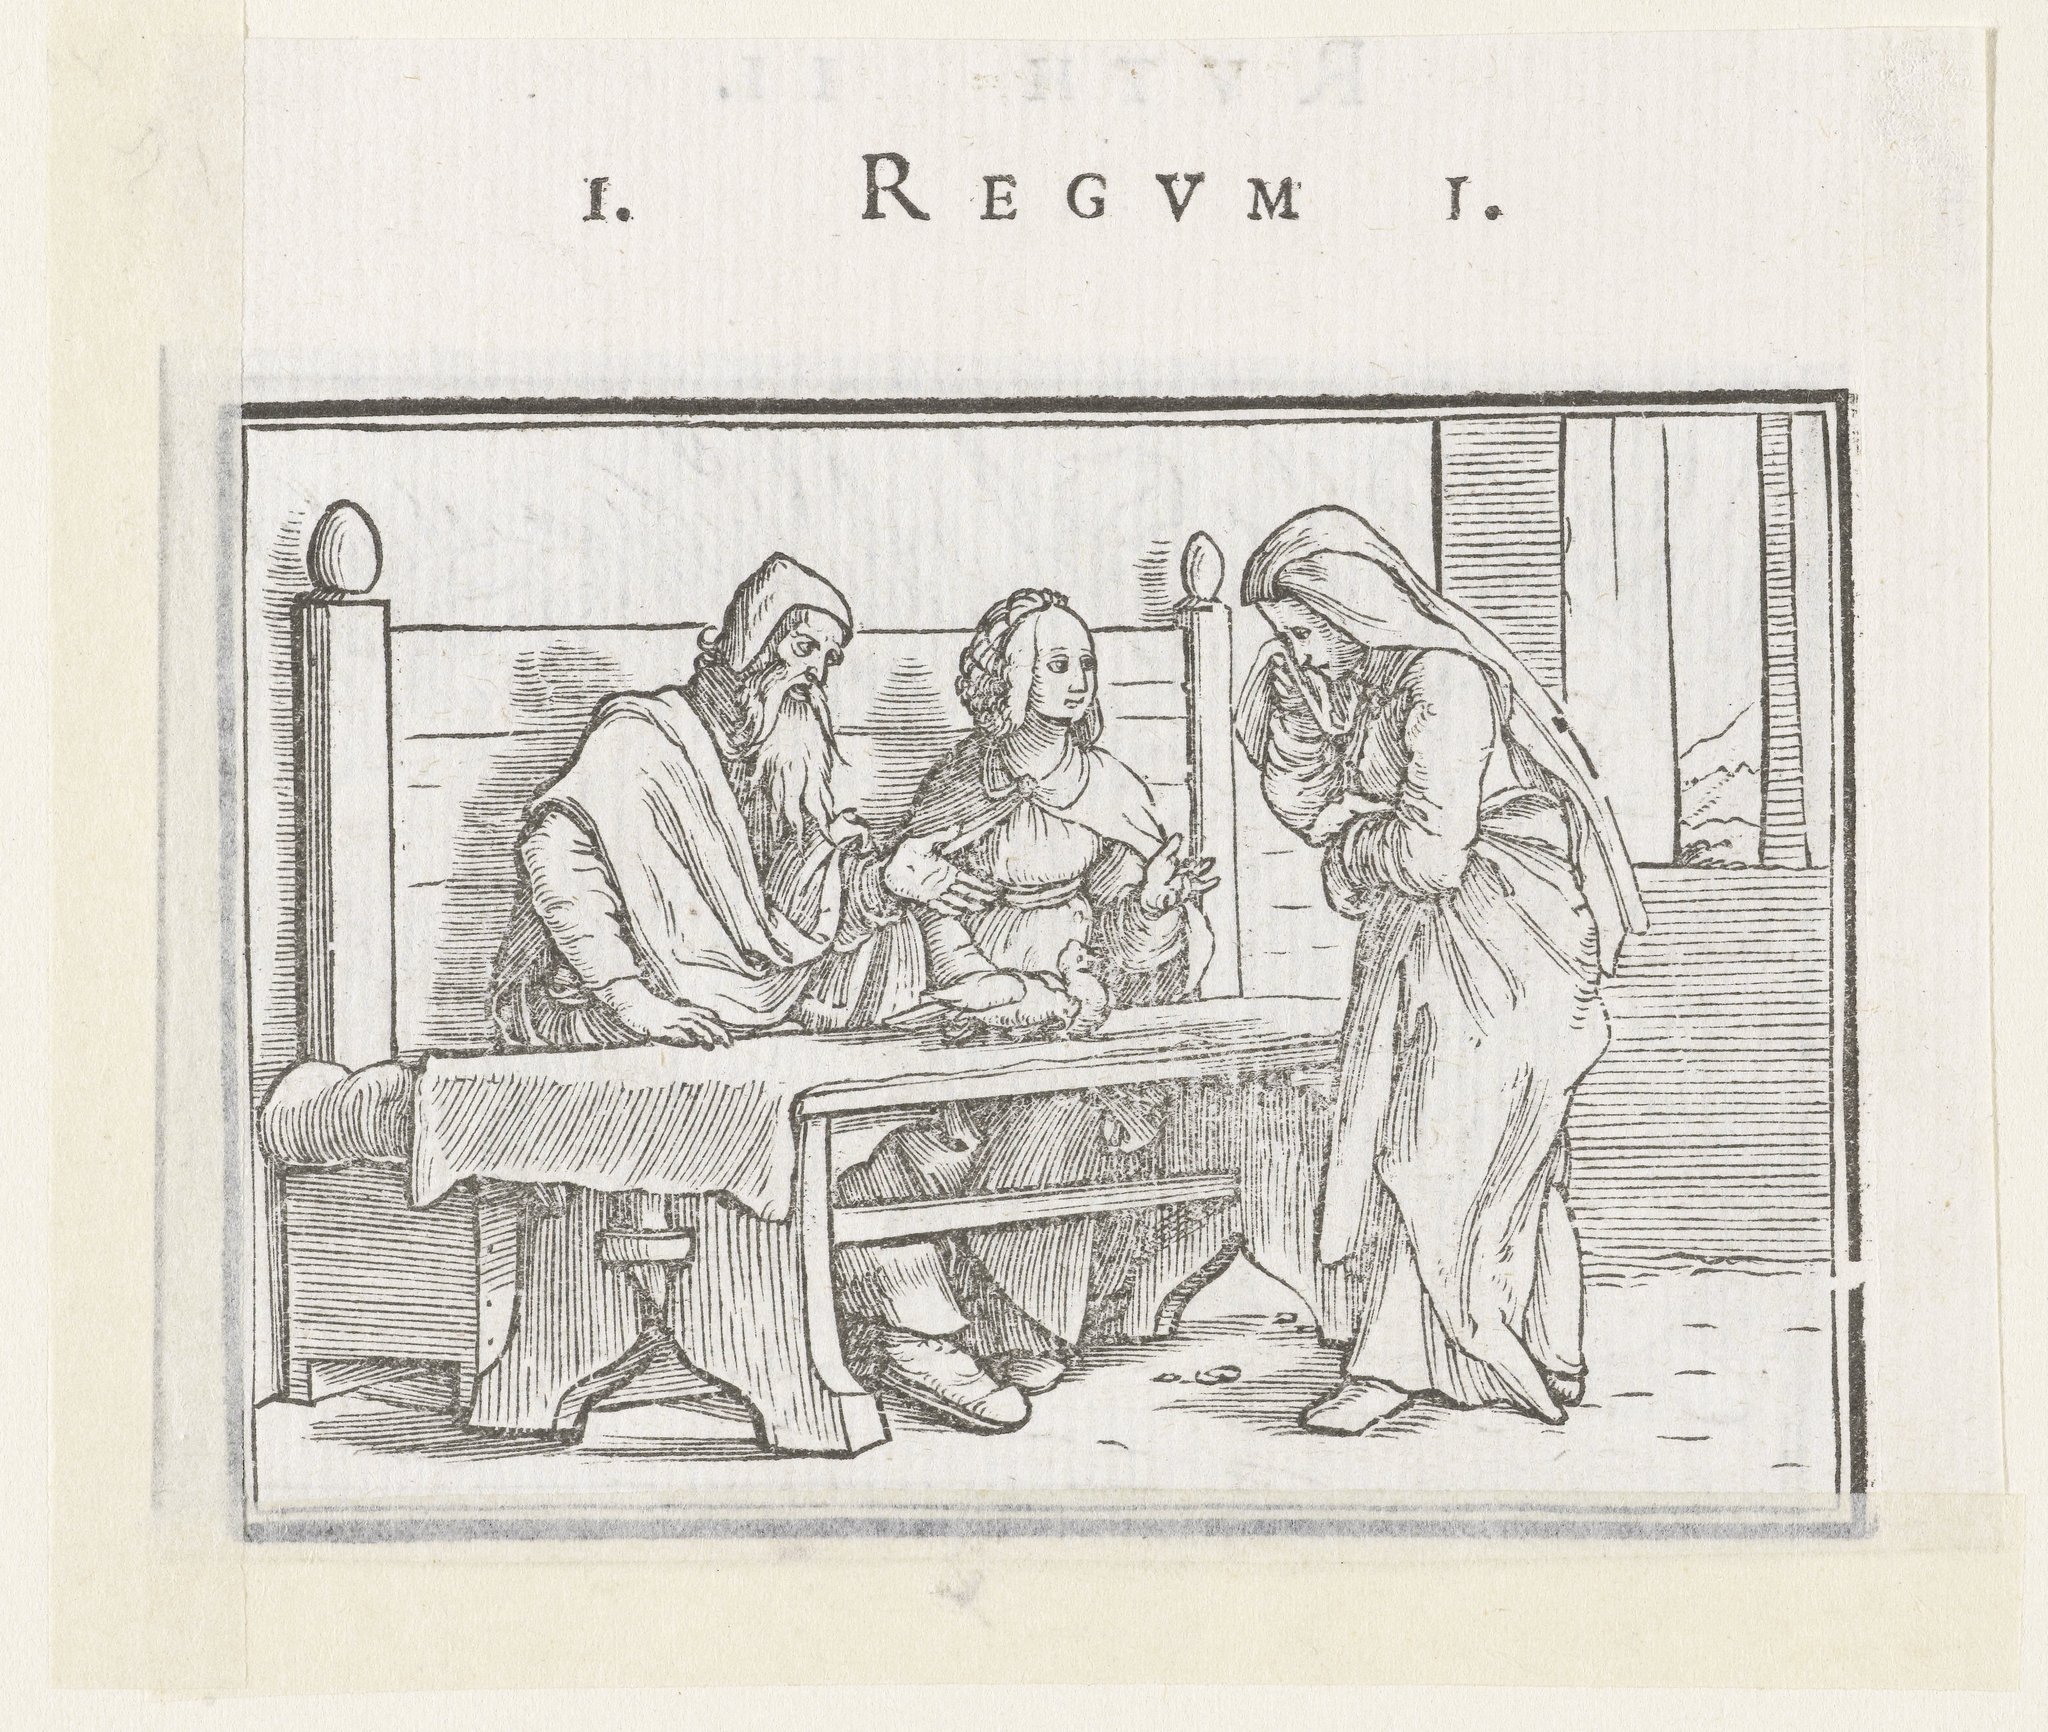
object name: print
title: Hanna weigert het eten dat Elkana haar aanbiedt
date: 1538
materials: paper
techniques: woodcut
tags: elkanah asking hannah why she weeps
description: Hanna is zo overmand door verdriet omdat ze geen kinderen krijgt dat ze het eten, dat ze krijgt van haar echtgenoot Elkana, weigert. Hij vraagt haar waarom ze huilt. In de marge boven de afbeelding staat de tekst Regvm I [Samuel 1].